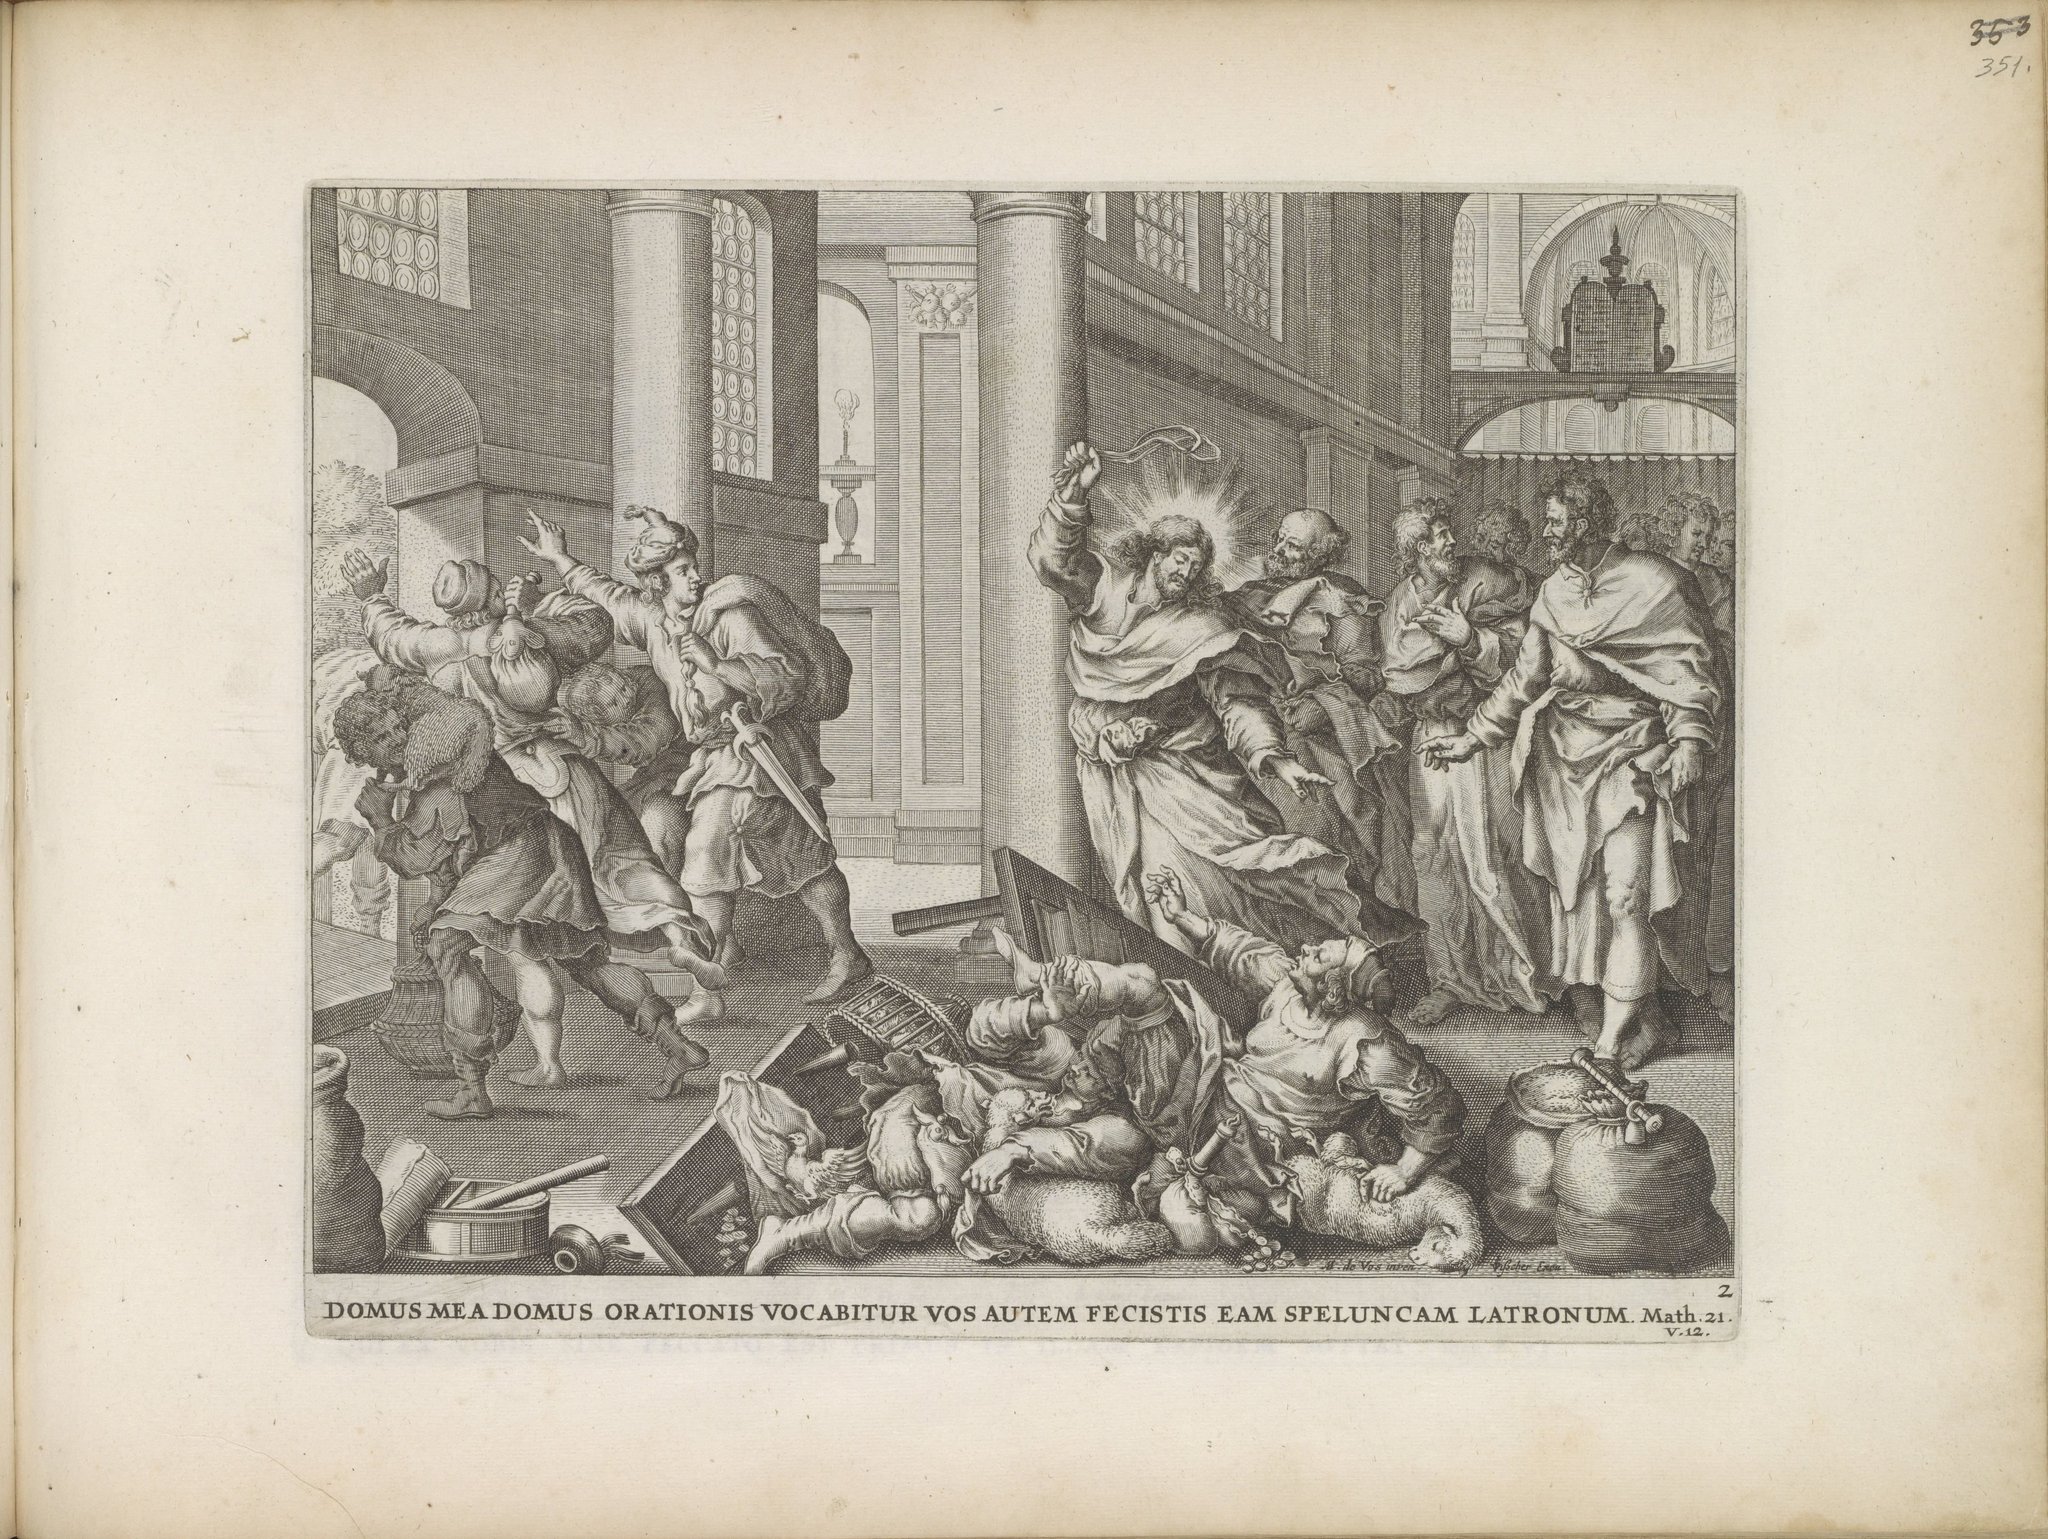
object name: album leaf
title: Christus verdrijft de handelaren en geldwisselaars uit de tempel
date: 1643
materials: paper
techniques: engraving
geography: amsterdam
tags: purification of the temple ('first' and 'second'): christ driving the money-changers from the temple with a whip (matthew 21:12-13; mark 11:15-17; luke 19:45-46; john 12:12-19)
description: Christus verdrijft met een zweep de handelaren en geldwisselaars uit de tempel. Links vluchten drie mannen weg. Op de voorgrond liggen twee mannen bij hun omgevallen tafels, geld en koopwaar op de grond. Onder de voorstelling een verwijzing in het Latijn naar de Bijbeltekst in Mat. 21:12. Deze prent maakt deel uit van een album.